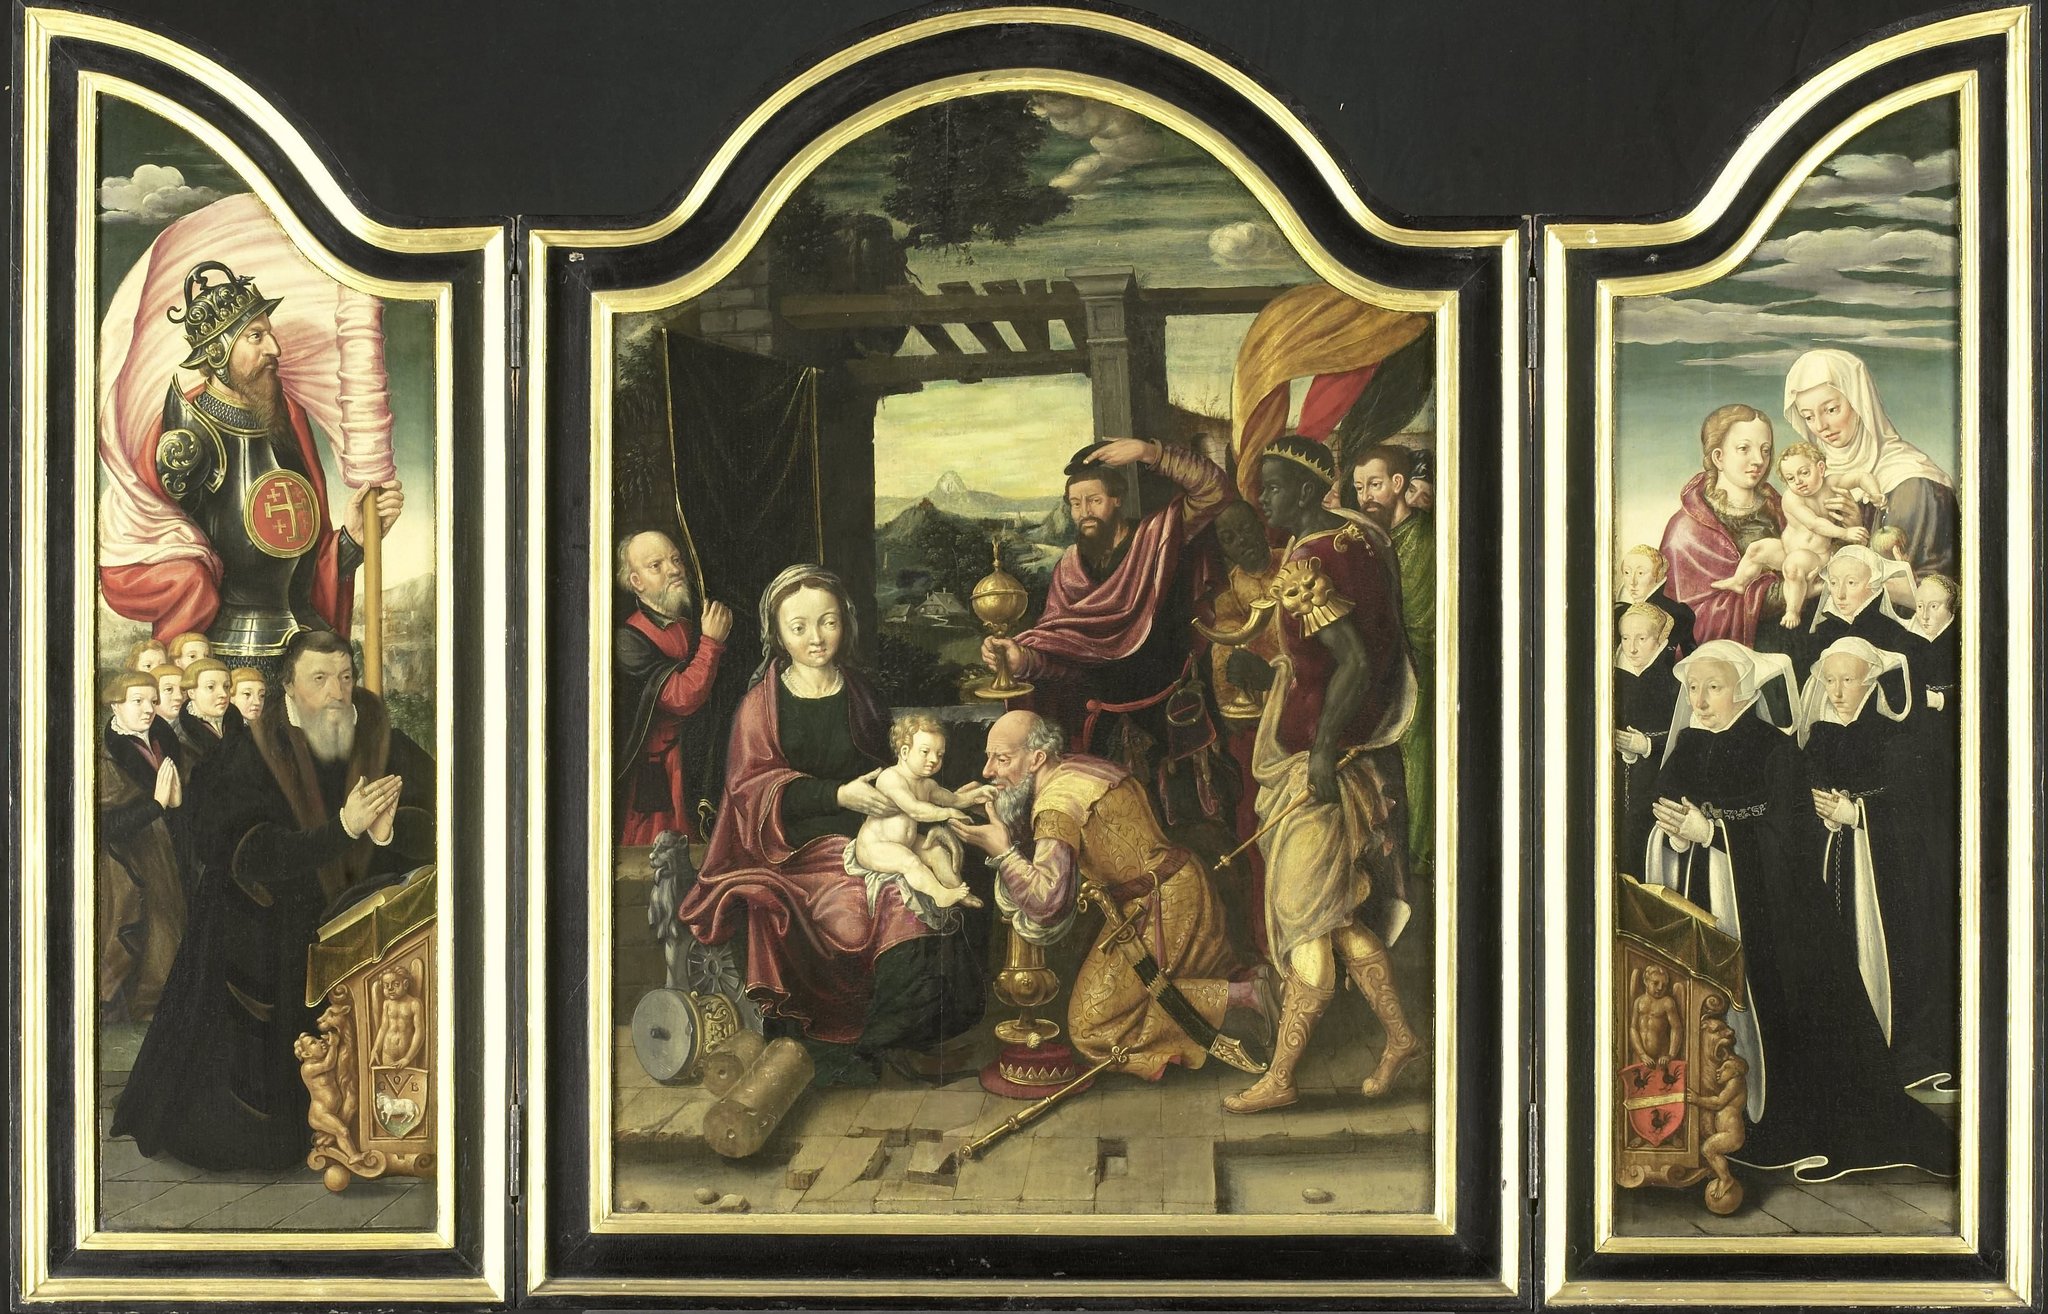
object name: triptych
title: Triptych with the Adoration of the Magi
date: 1520-1600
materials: oil, panel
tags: adoration of the kings: the wise men present their gifts to the christ-child (gold, frankincense and myrrh), the warrior martyr george (georgius) ... (+ donor(s), supplicant(s) wether or not with patron saint(s)), 'anna selbdritt', i.e. anna, mary and christ-child close together (+ donor(s), supplicant(s), wether or not with patron saint(s))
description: Drieluik. Op het middenpaneel de aanbidding der koningen. Een koning knielt en kust de hand van het Christuskind, hij heeft zijn kroon en scepter op de grond gelegd. Rechts de andere koningen met hun geschenken en gevolg. Op het linker zijpaneel de geknielde mannelijke schenker met zes zonen en de heilige Joris met een vaandel. Op de lessenaar het wapen van de familie Van Rooy. Op de rechter zijpaneel de geknielde vrouwelijk schenker met vijf dochters en de heilige Anna-te drieën. Hier het wapen van de familie Francken (of Vrancken).